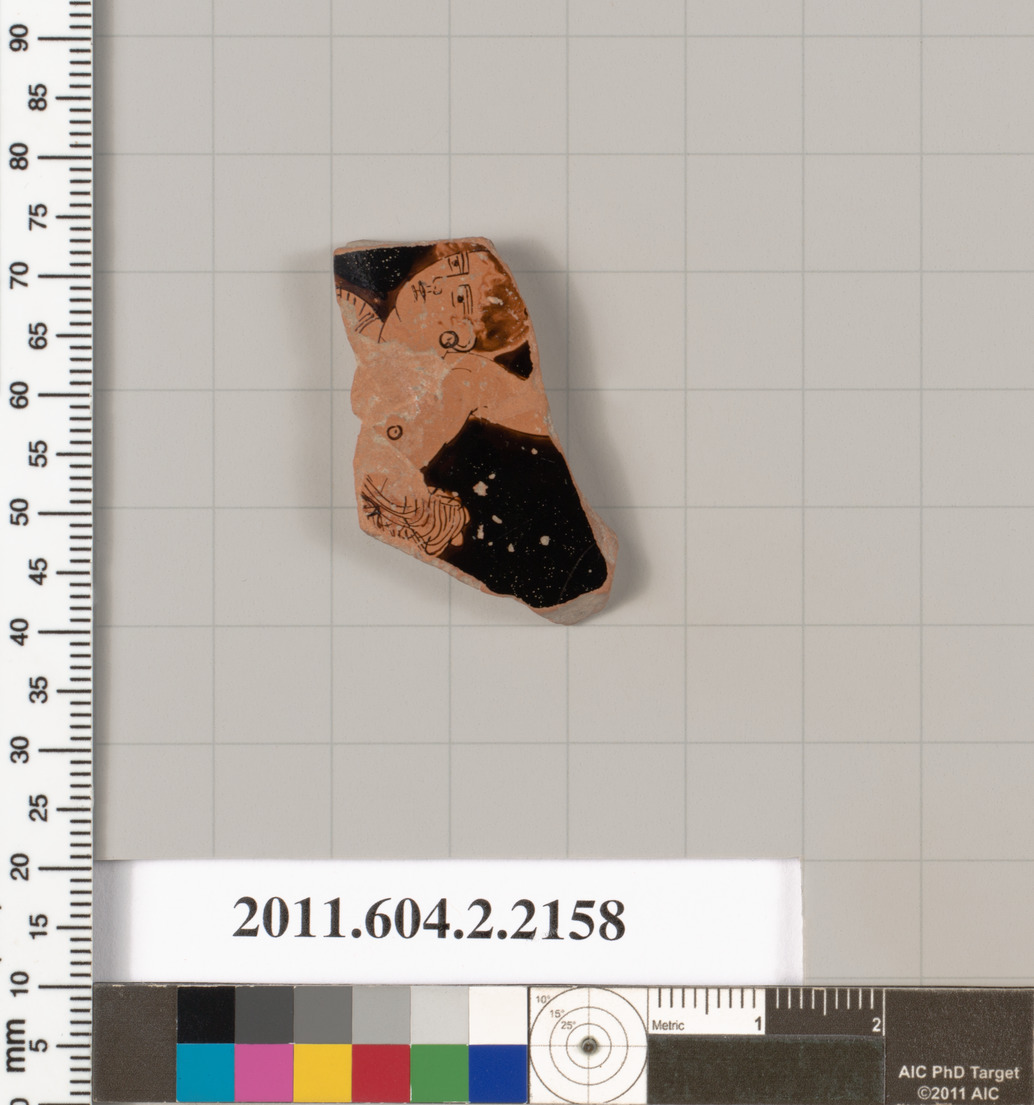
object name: pot fragment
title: Terracotta fragment of a squat lekythos (oil flask)?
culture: greek, attic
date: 440-420 BCE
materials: terracotta